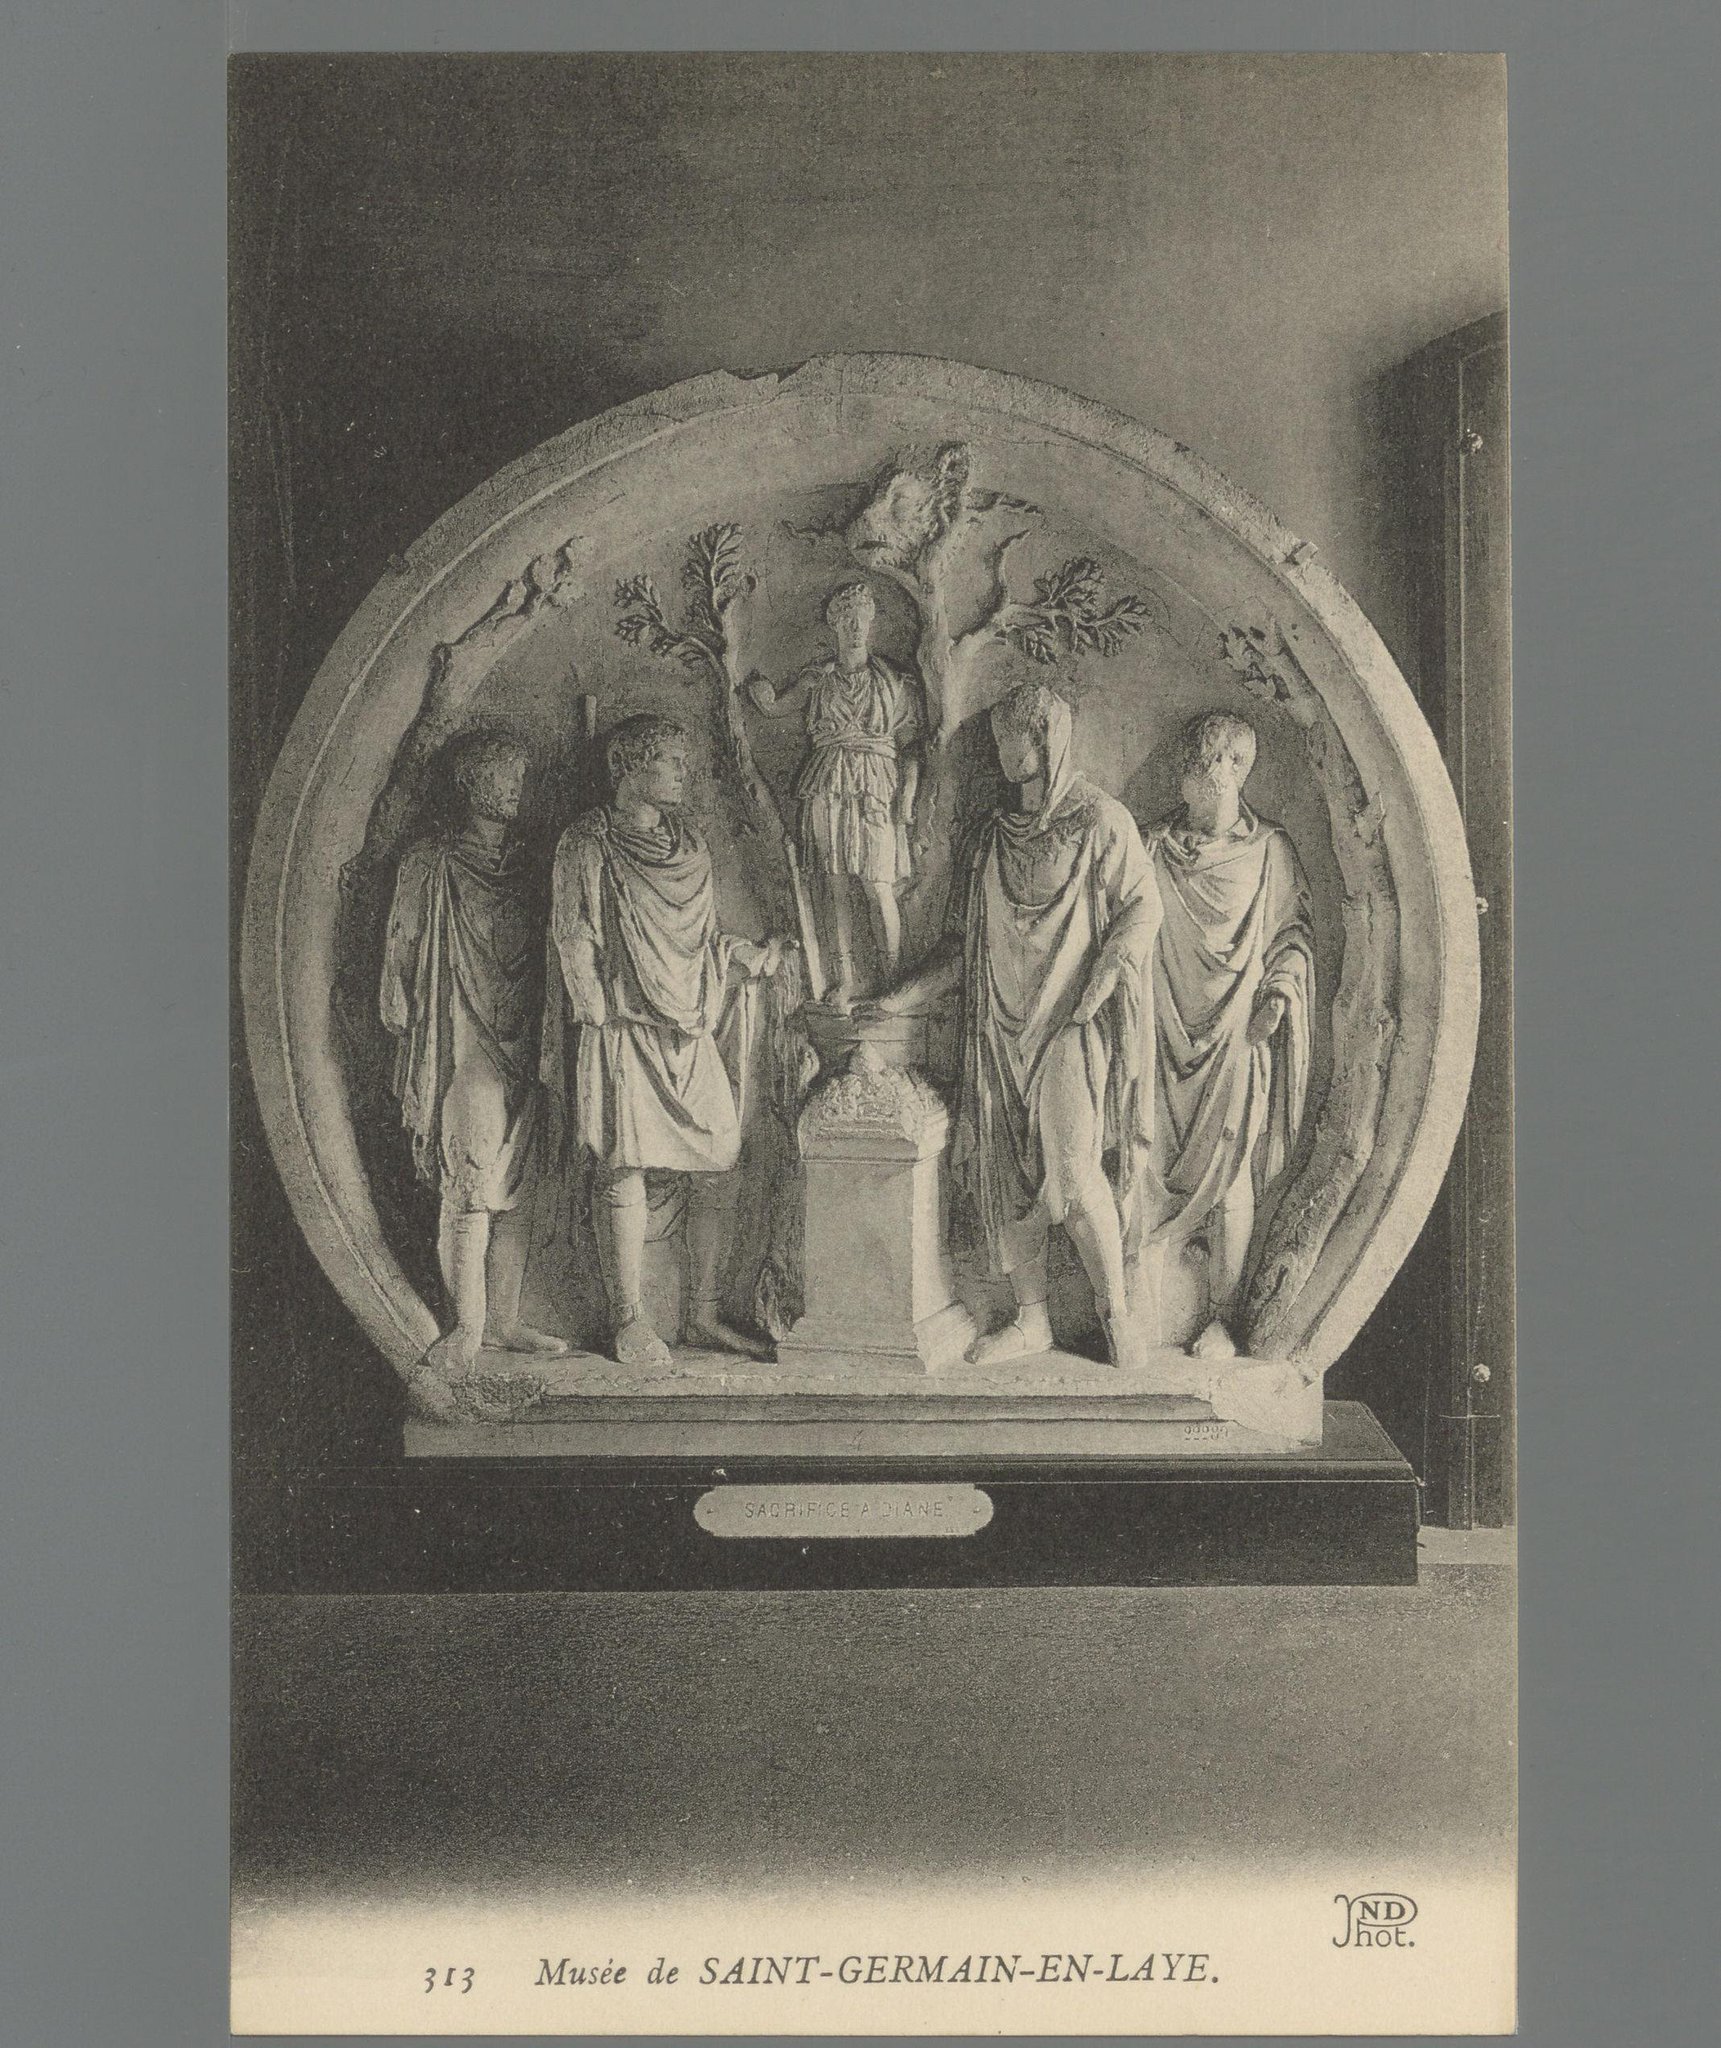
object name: photomechanical print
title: Sacrifice à Diane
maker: Anonymous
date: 1903-1918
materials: cardboard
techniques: photograph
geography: saint-germain-en-laye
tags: permanent exhibition, museum, sculpture